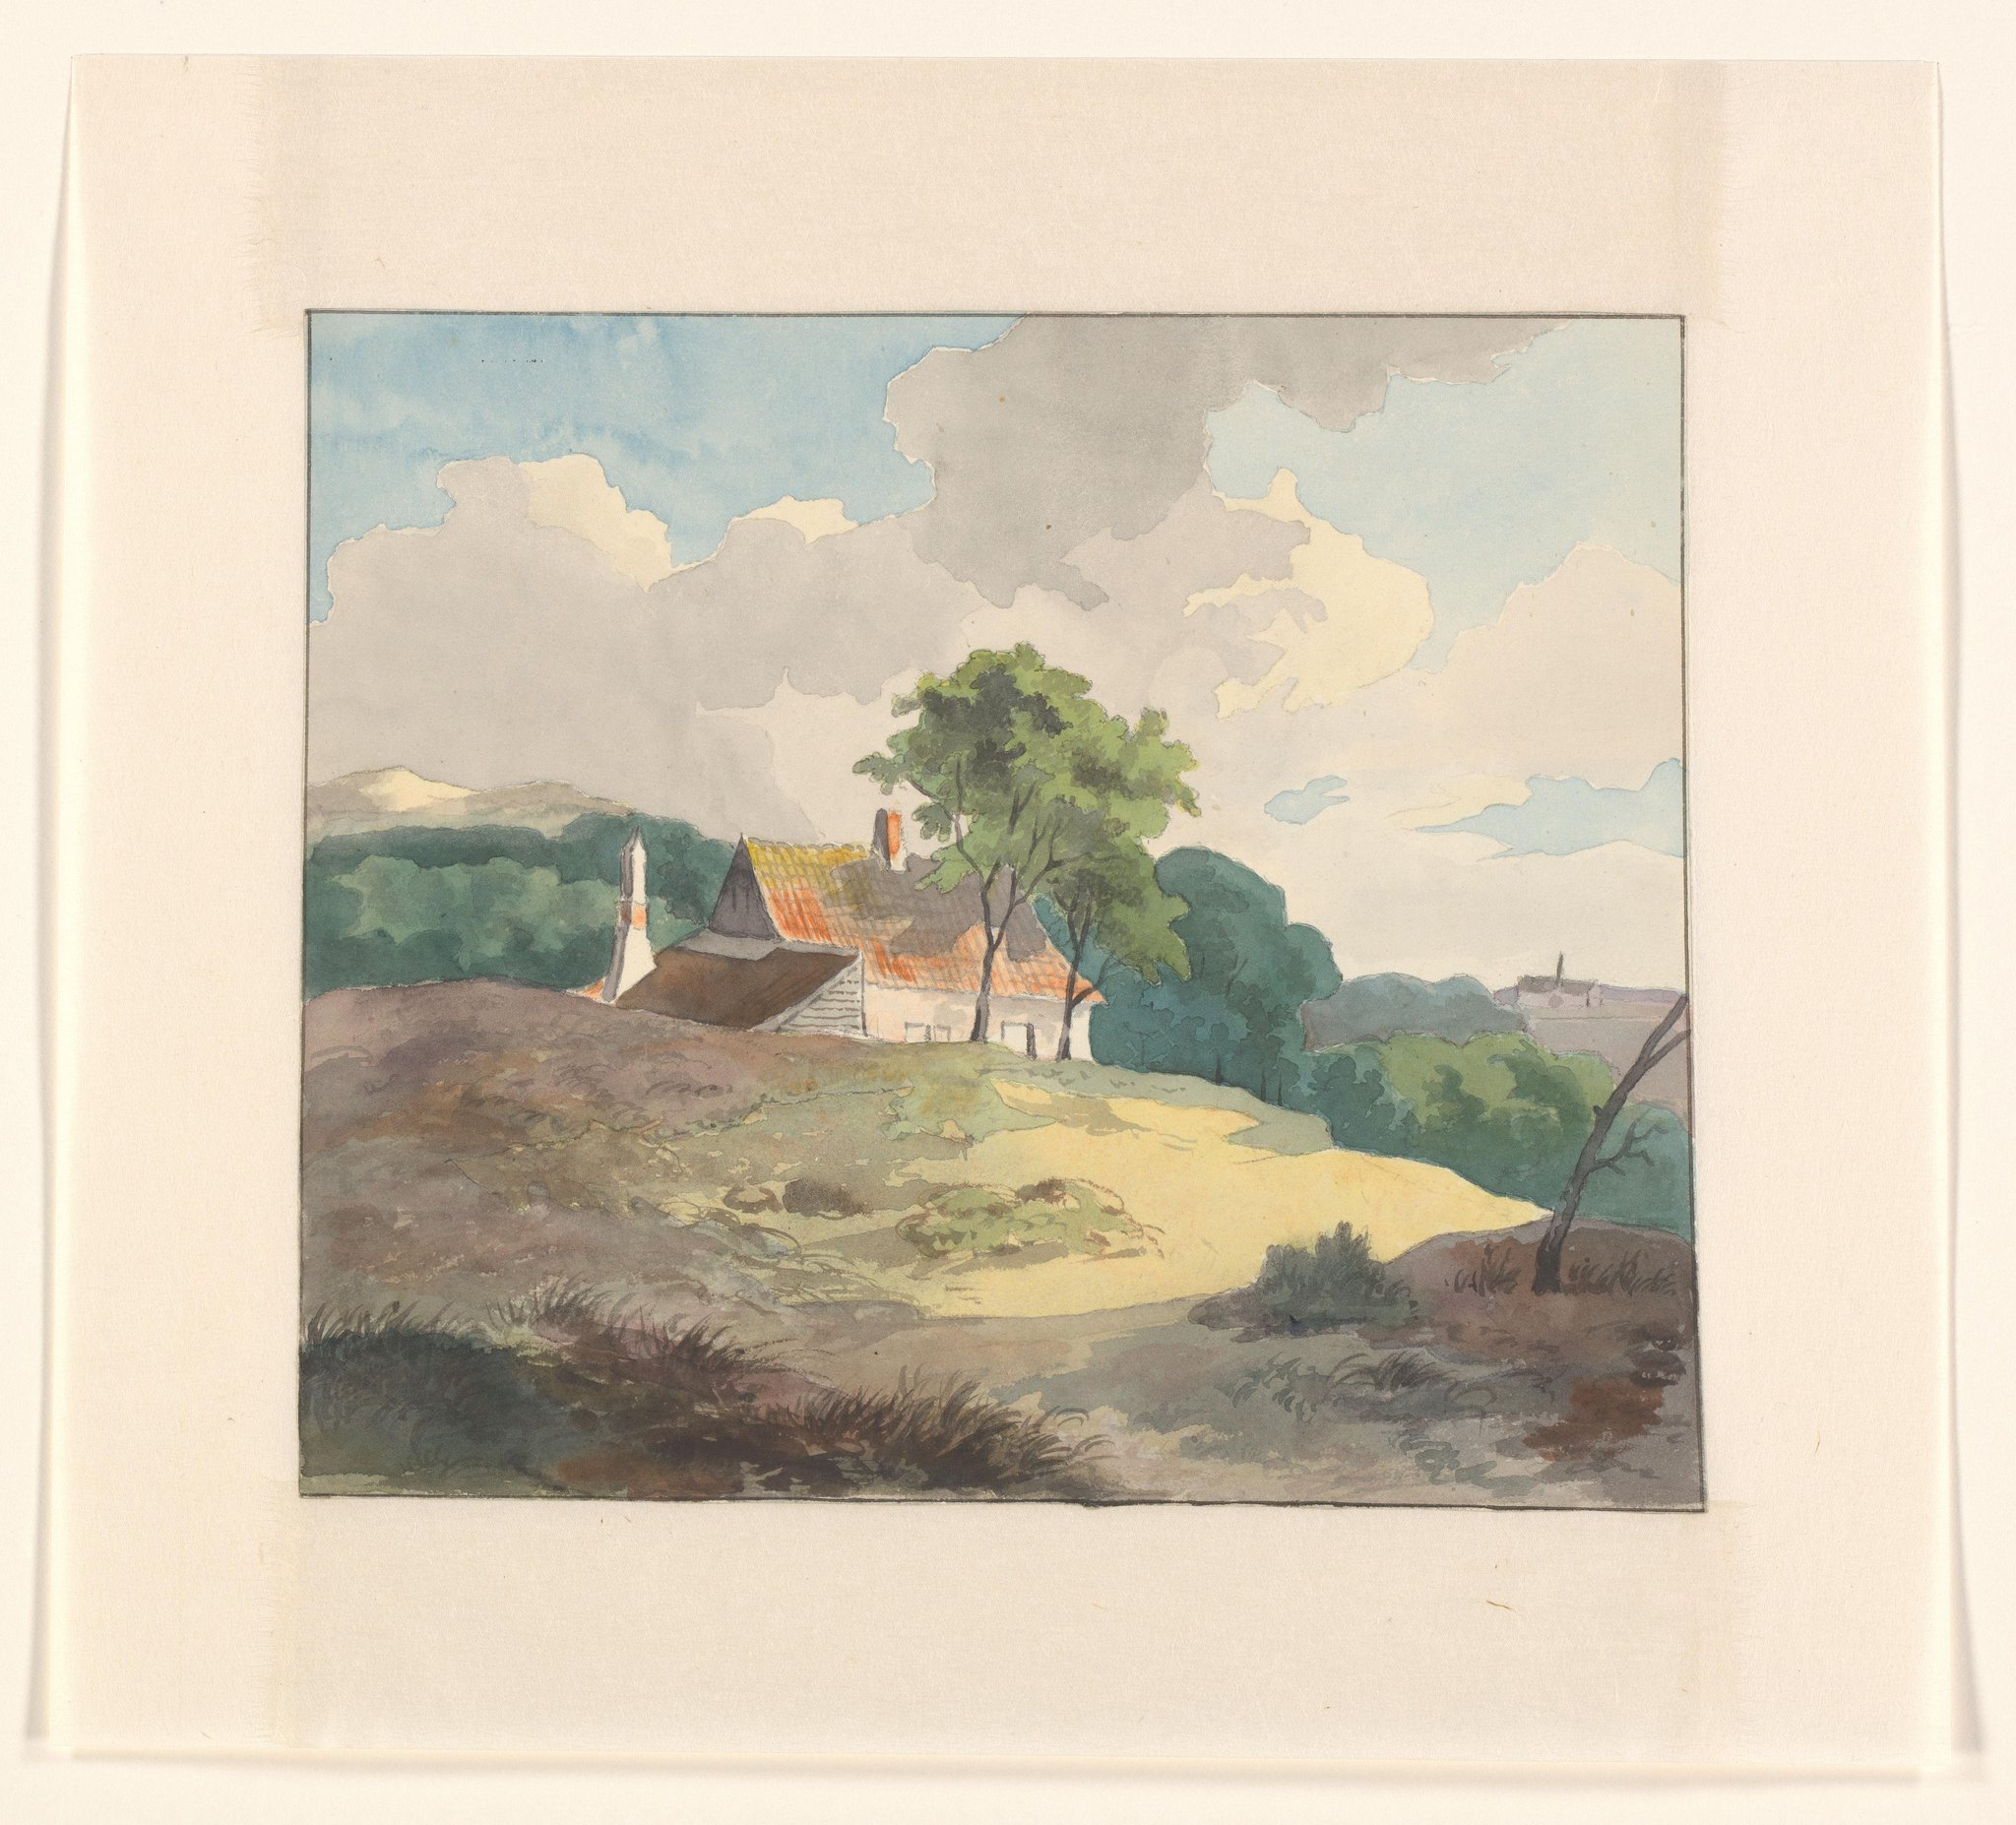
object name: drawing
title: Huis in een heuvellandschap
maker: johannes van reijn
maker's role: draughtsman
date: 1800-1900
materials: paper, pencil, watercolor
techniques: brush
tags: farm or solitary house in landscape